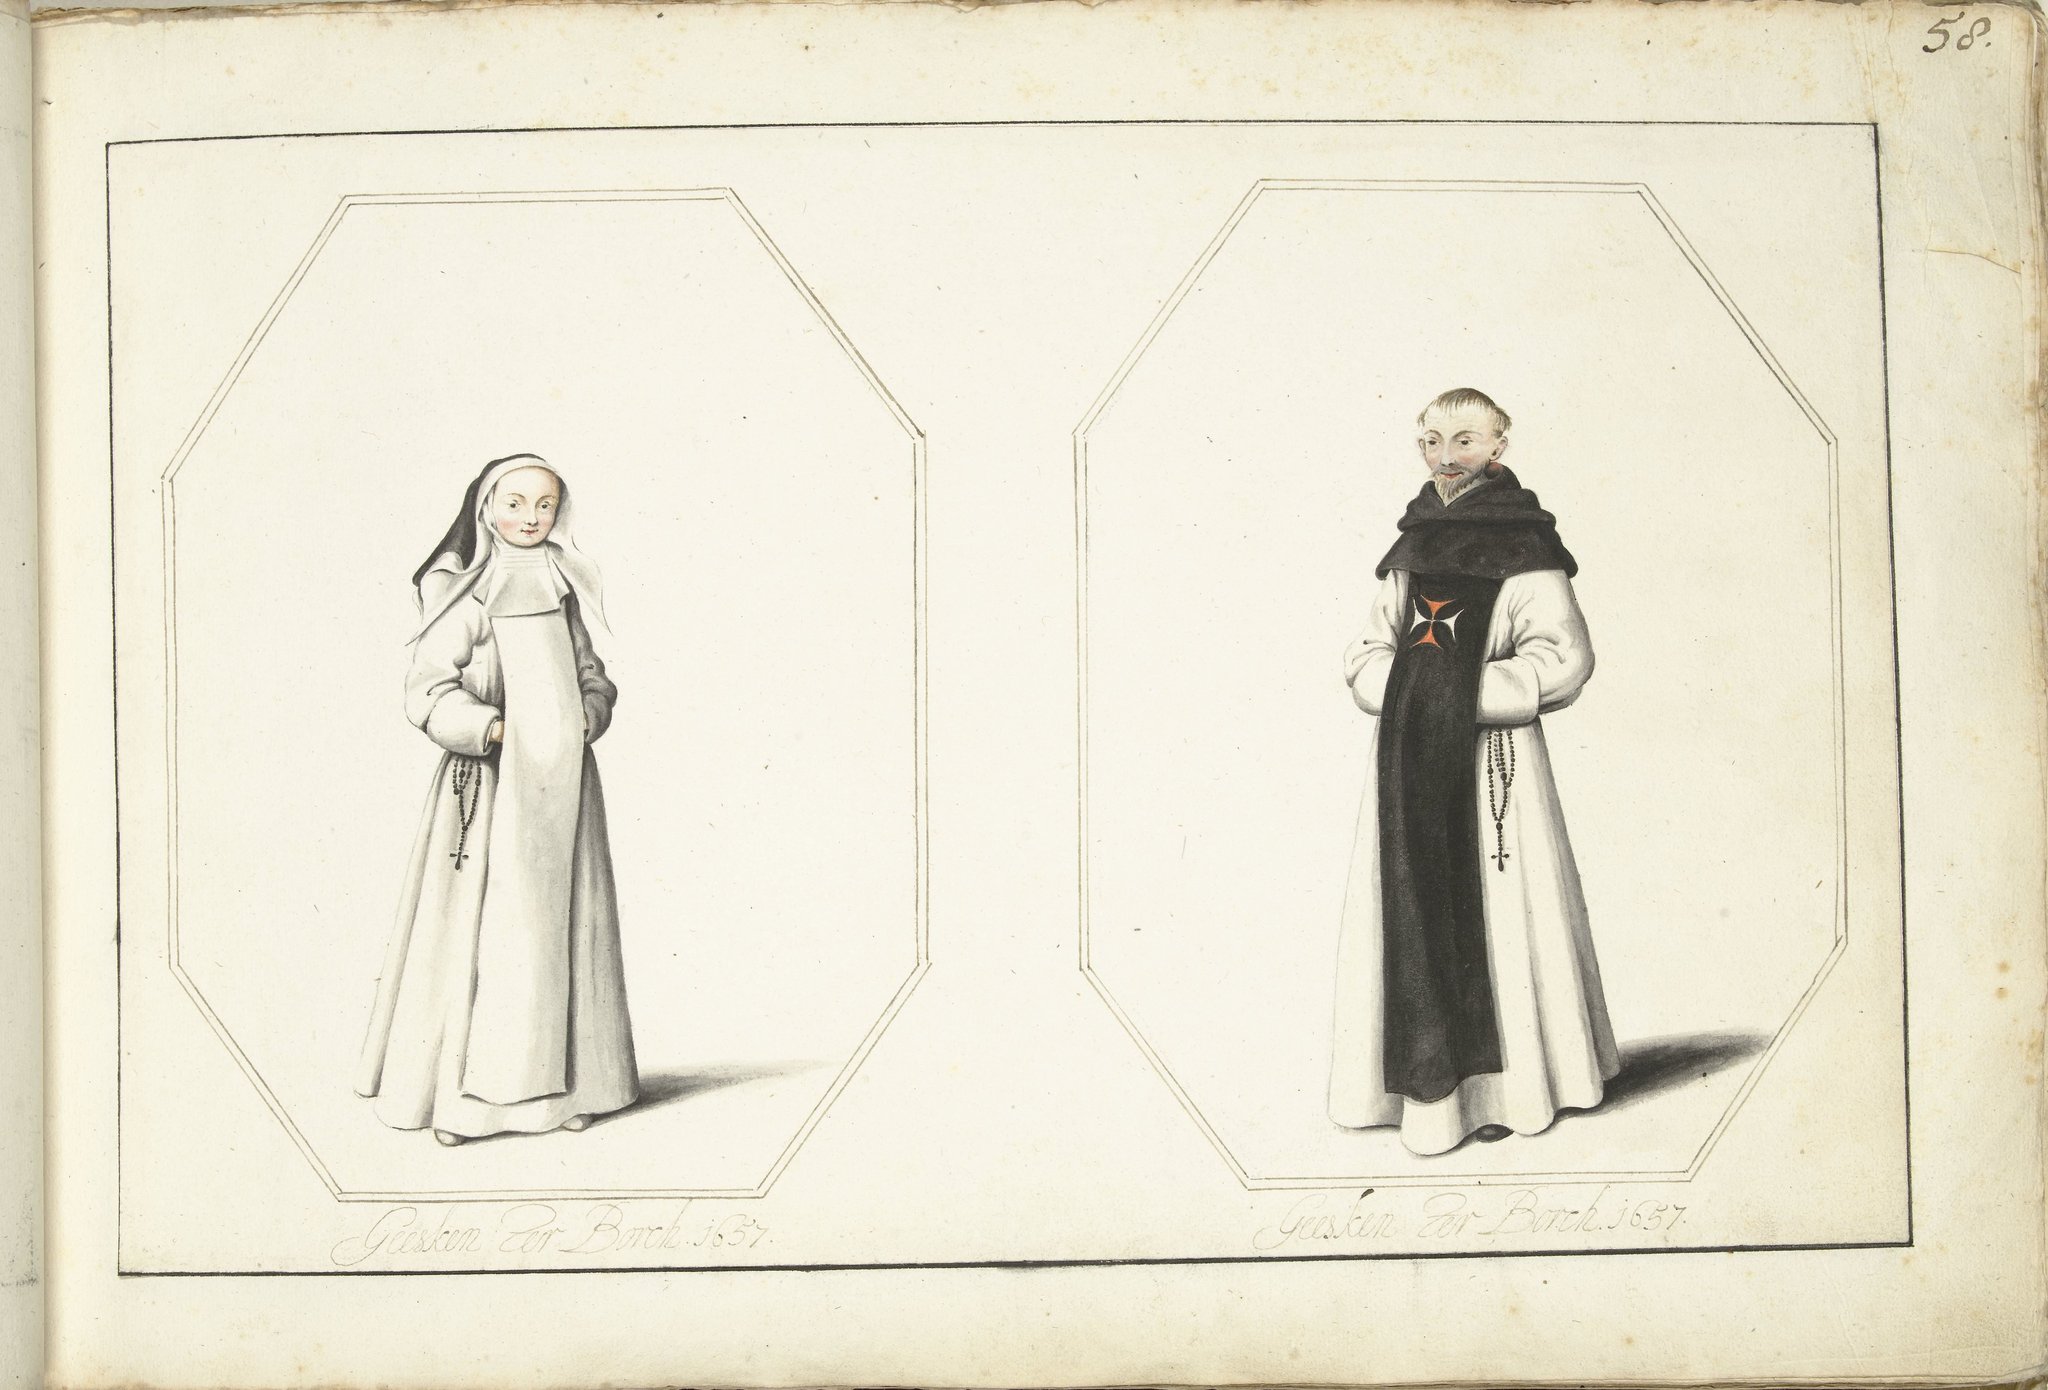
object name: drawing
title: Staande non en staande broeder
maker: gesina ter borch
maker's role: draughtsman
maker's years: 1633-1690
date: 1657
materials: paper, watercolor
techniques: brush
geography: zwolle